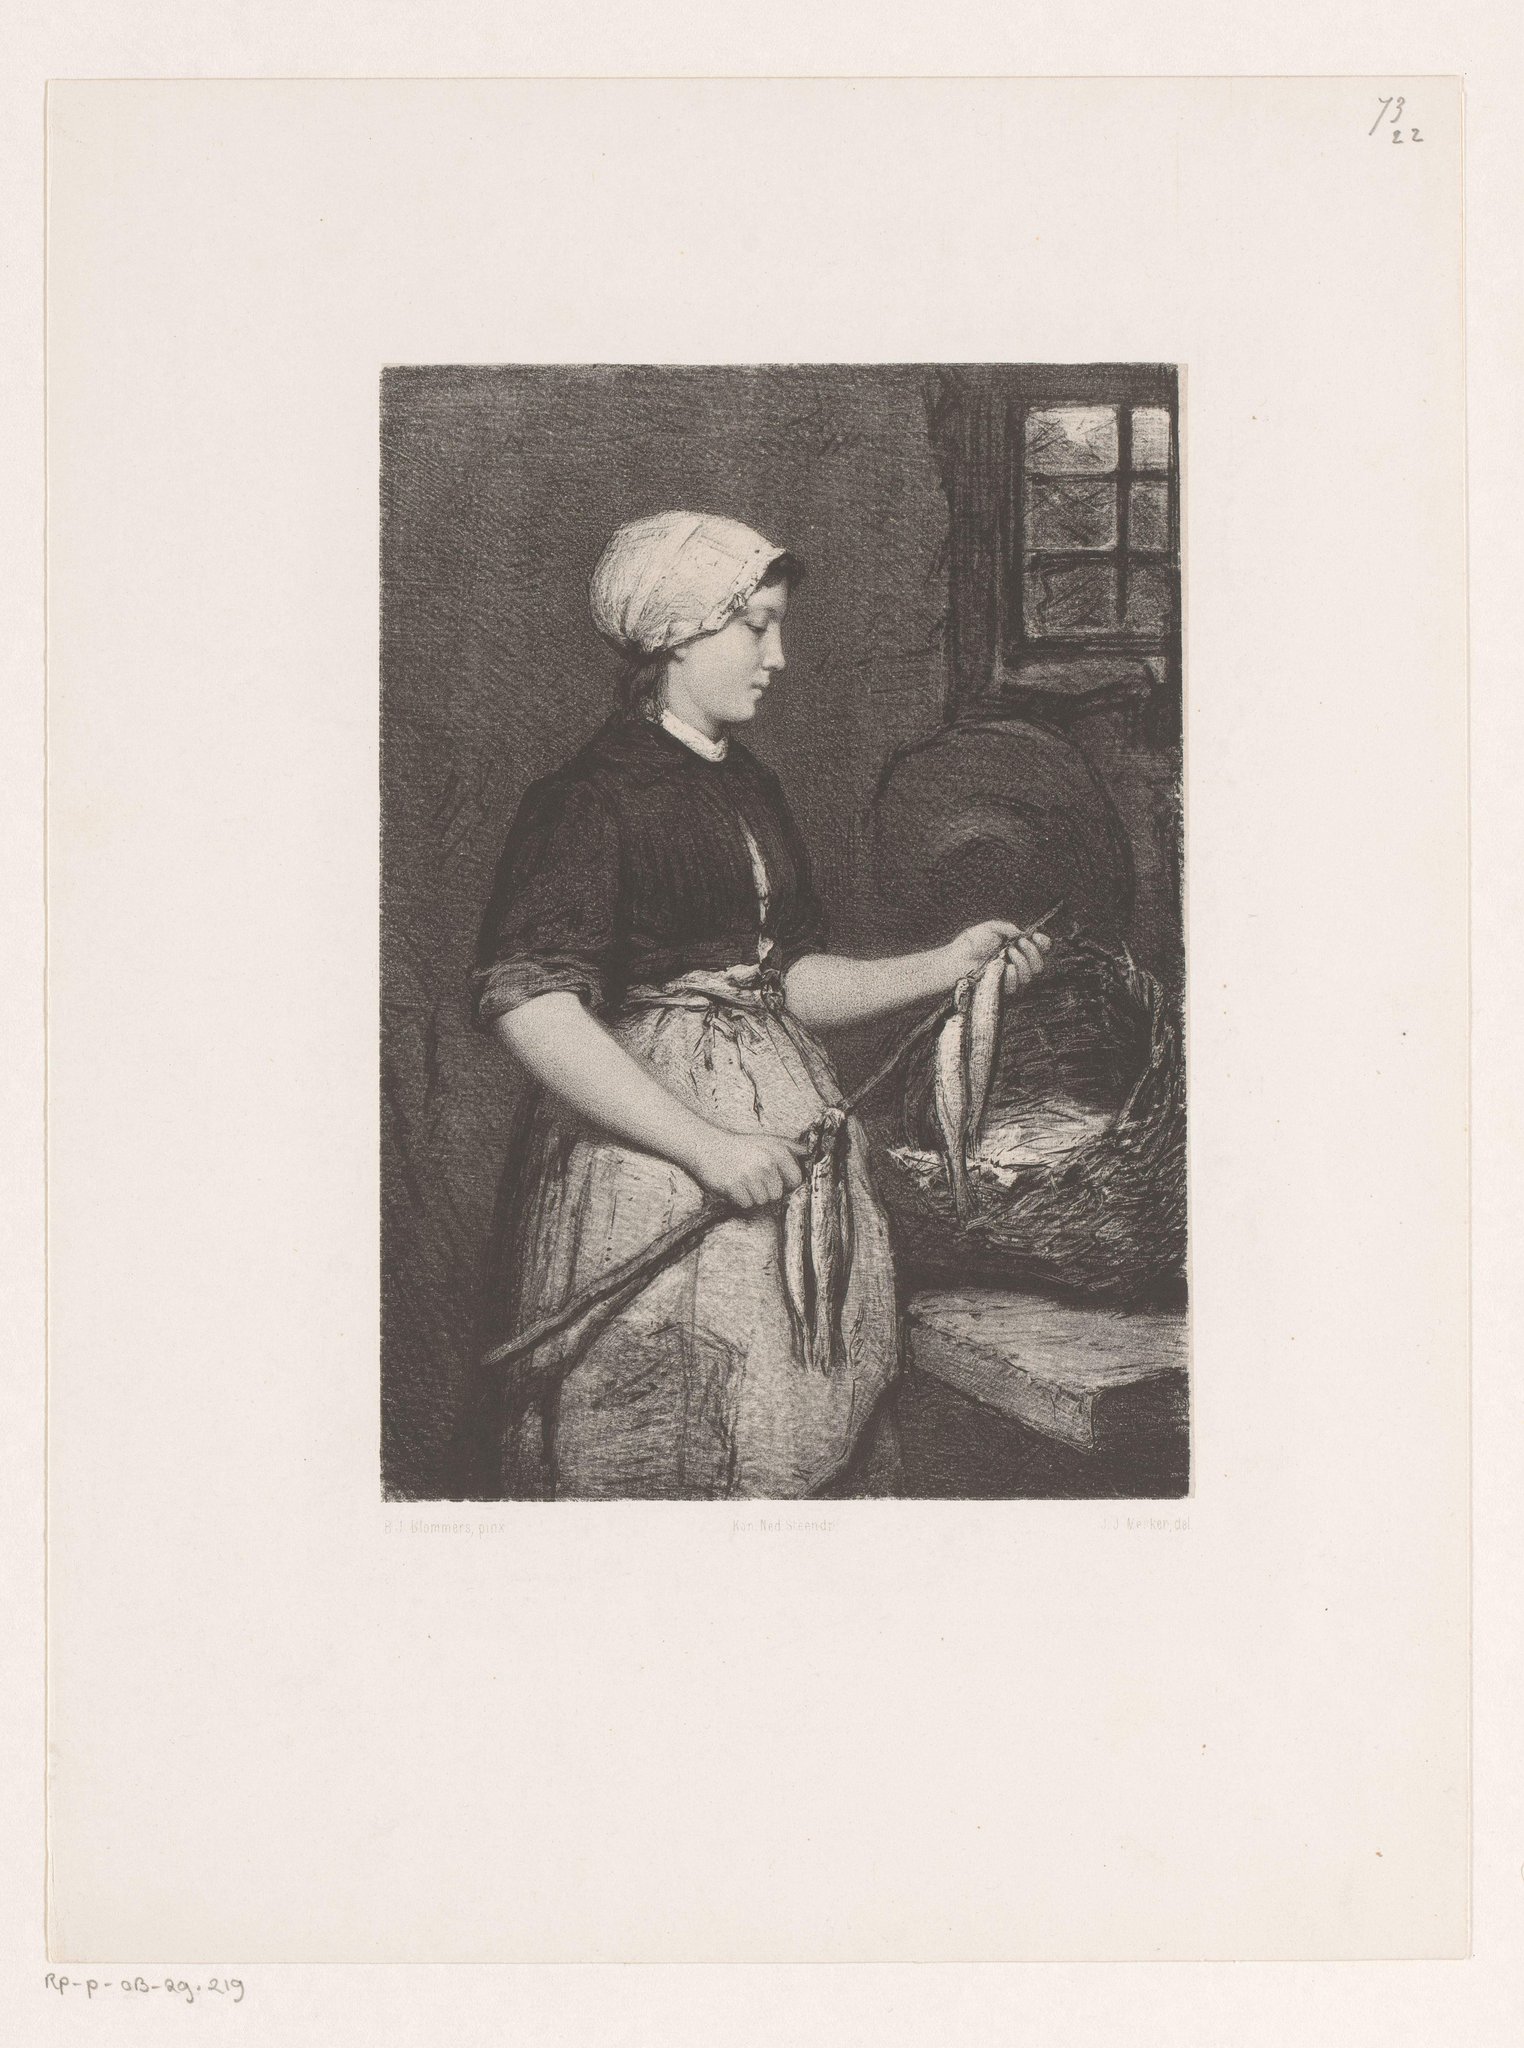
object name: print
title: Vrouw rijgt vissen aan een stok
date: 1867-1874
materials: paper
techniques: lithograph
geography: the hague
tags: adult woman, fishes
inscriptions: collector's mark: Lugt 2228